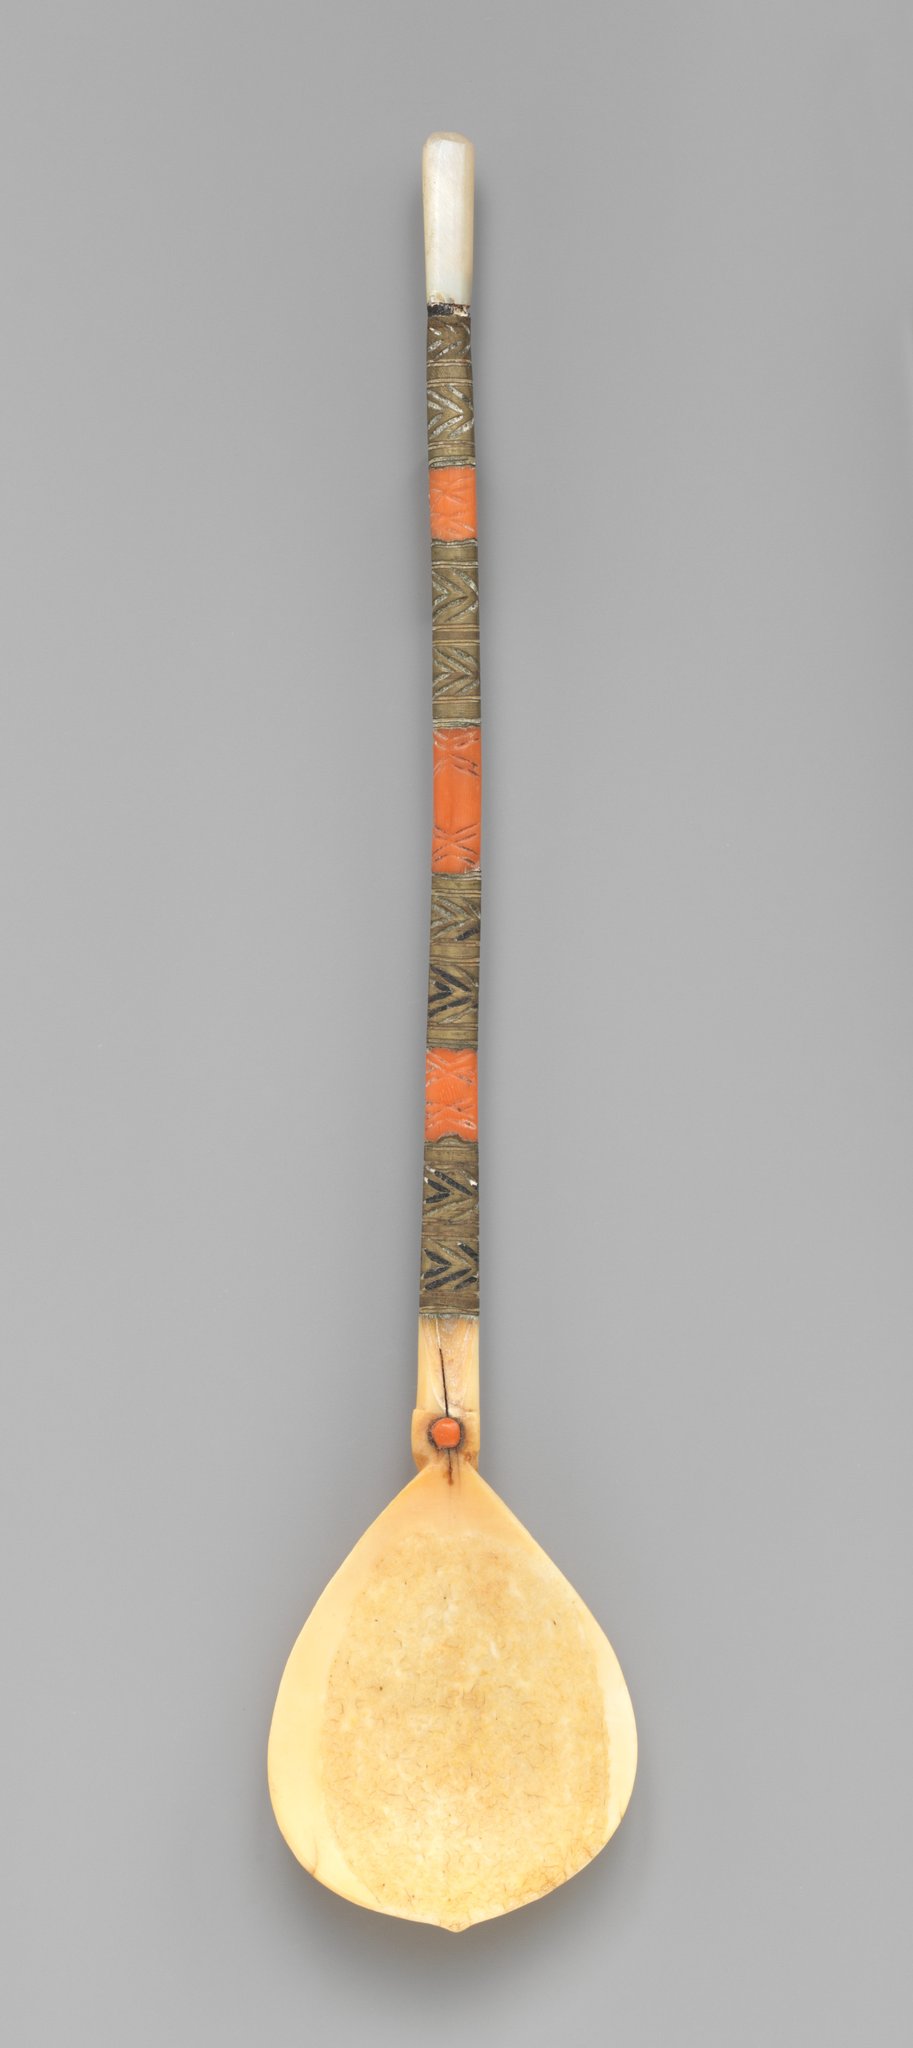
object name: spoon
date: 1701-1800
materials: bone, brass, coral, mother of pearl